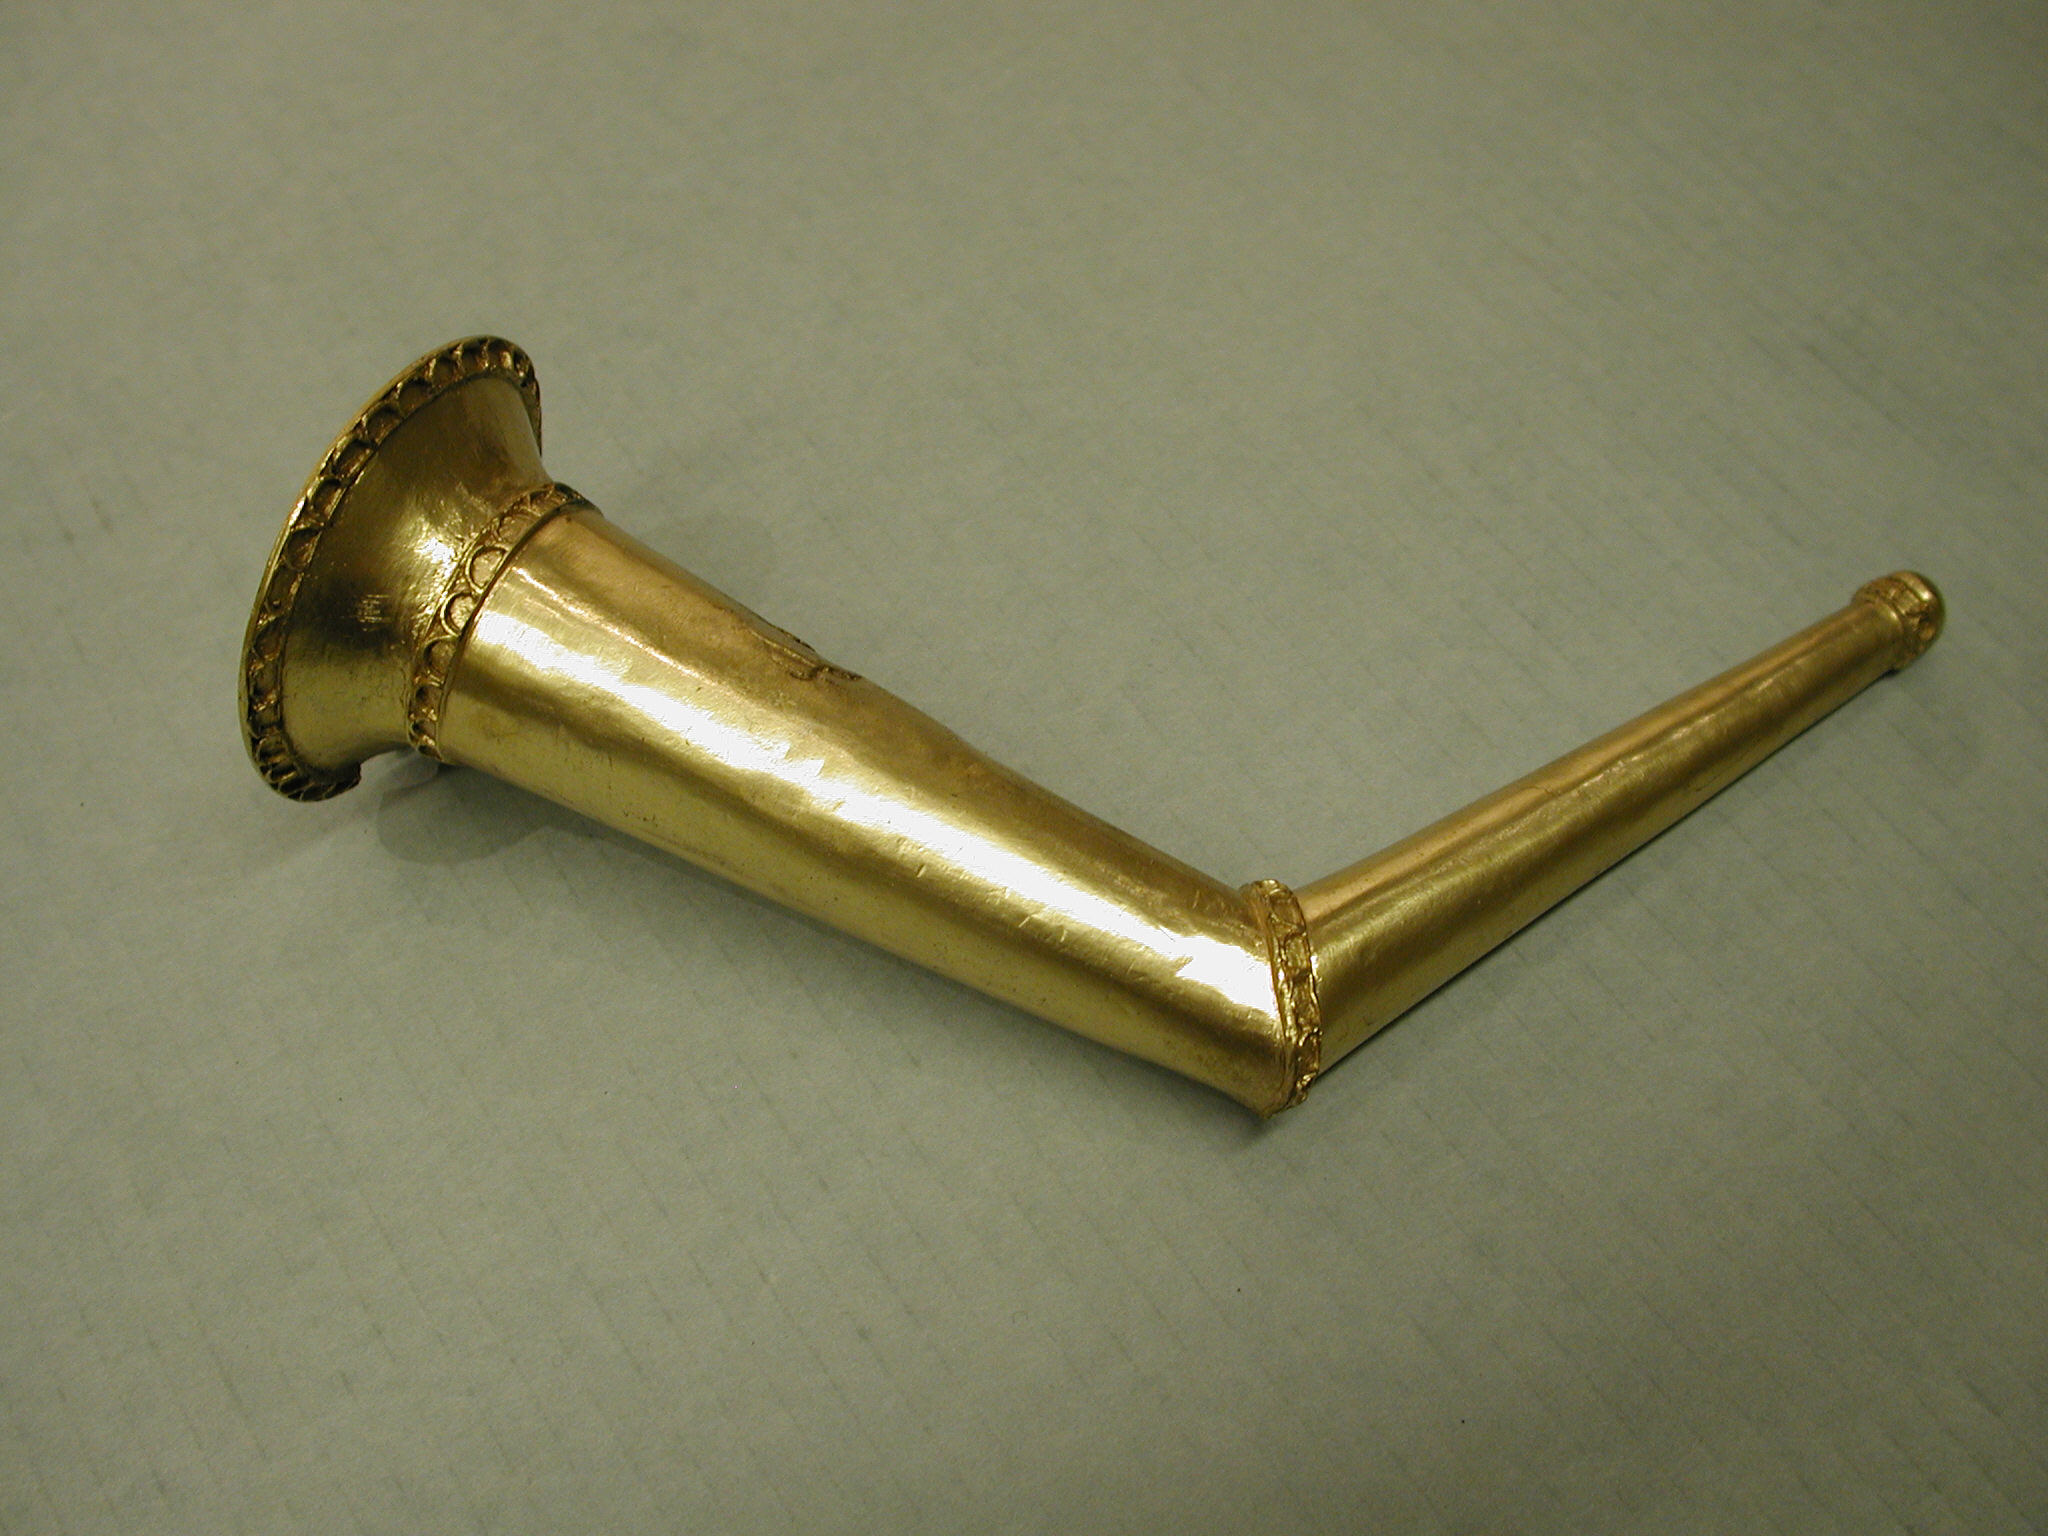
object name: horn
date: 1801-1900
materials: metal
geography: hungary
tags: horns